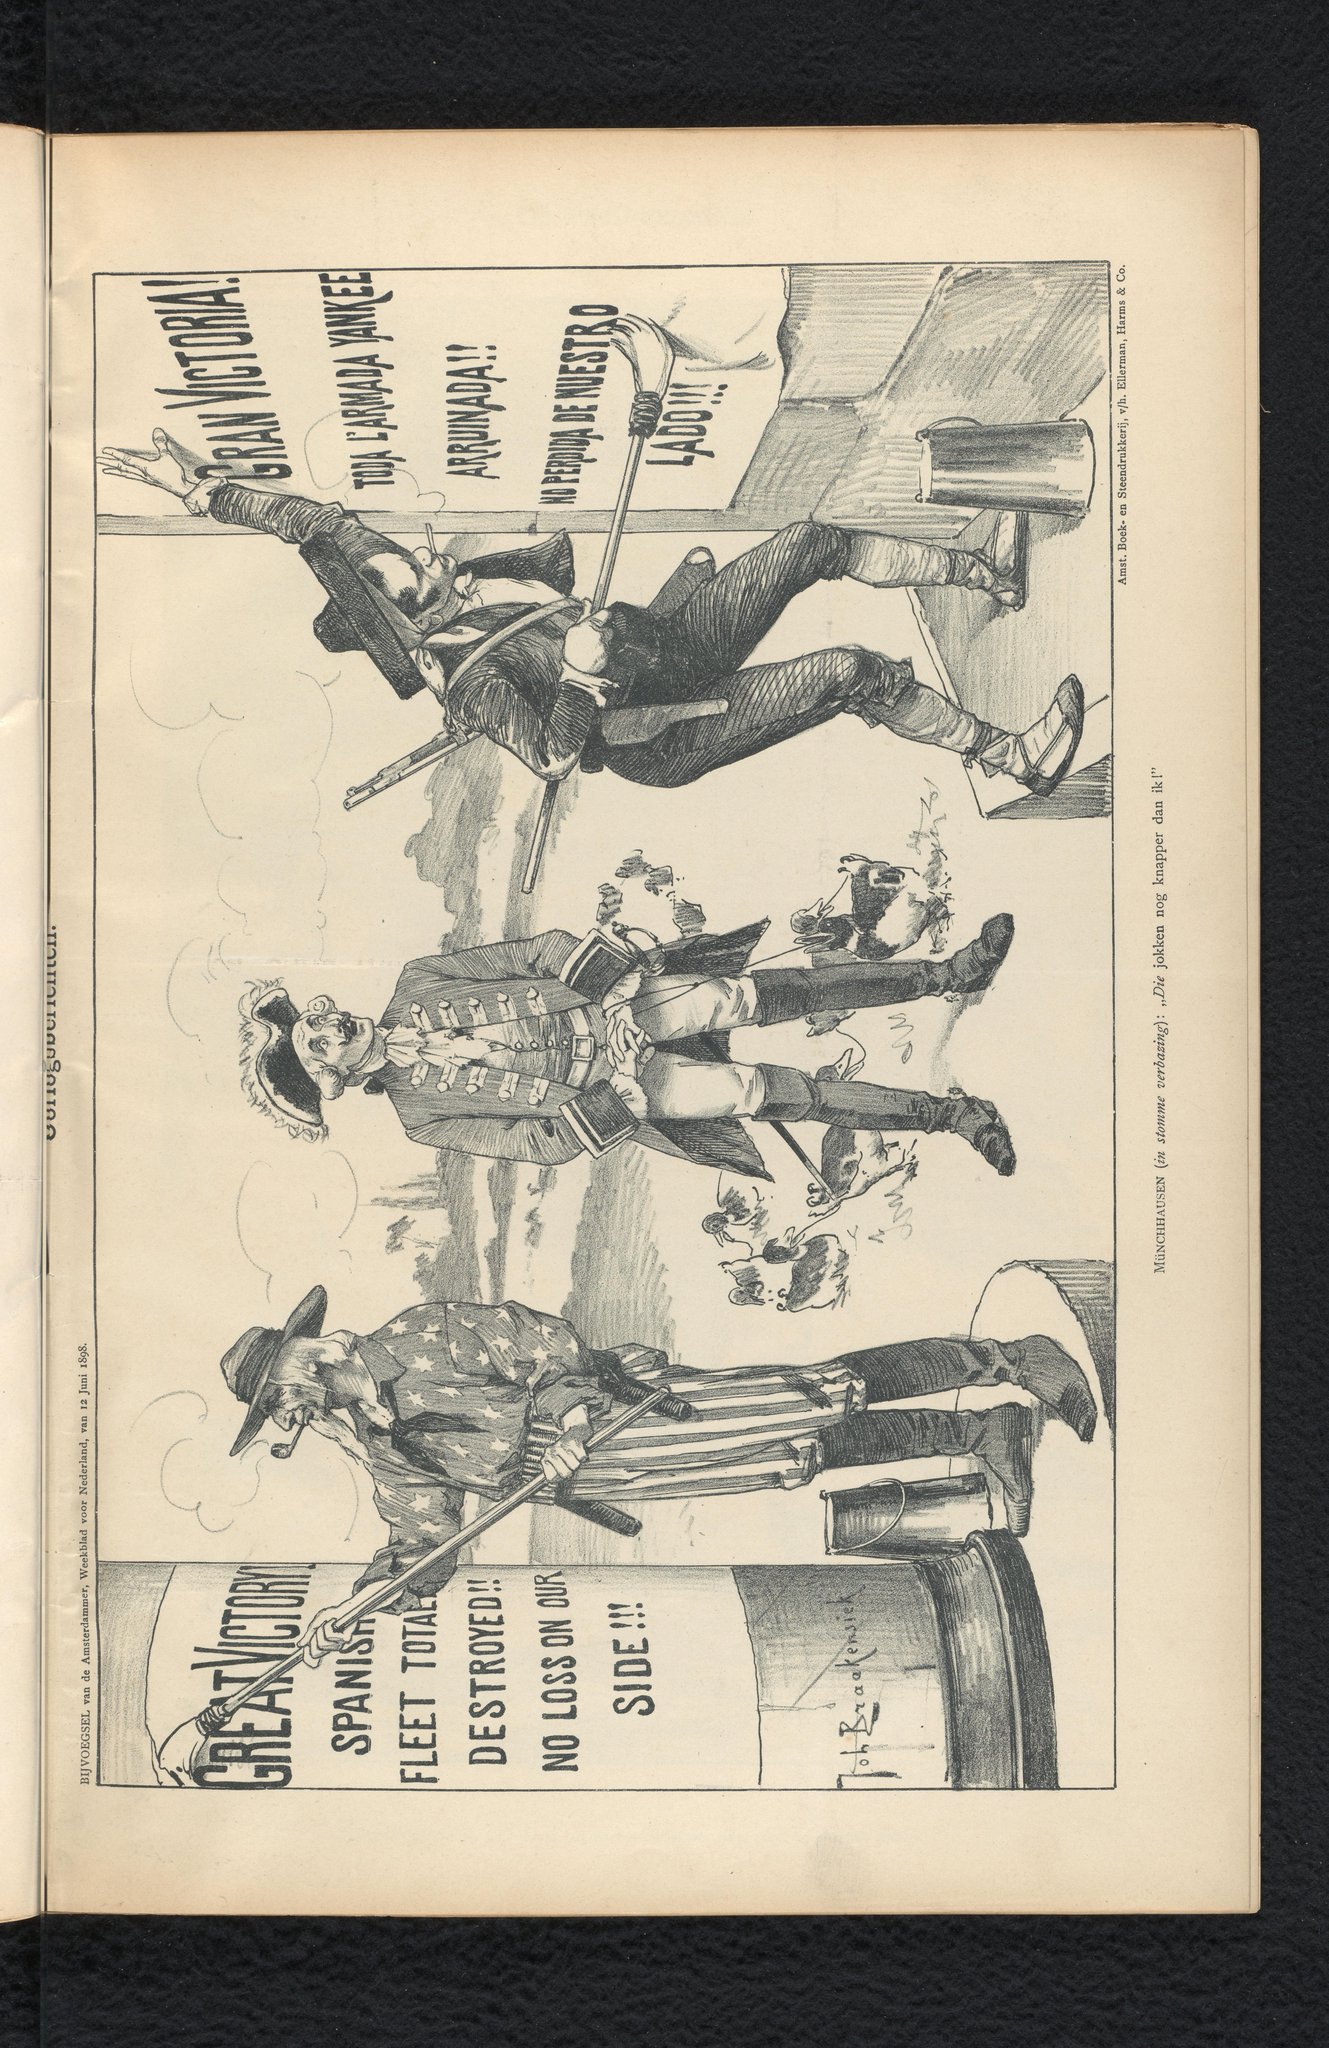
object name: cartoon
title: Oorlogsberichten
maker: johan braakensiek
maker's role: draughtsman, print maker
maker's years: 1858-1940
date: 1898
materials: paper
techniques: lithograph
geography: netherlands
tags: political propaganda, personifications of countries, nations, states, districts, etc., poster-pillar, baron münchausen, newspaper, news-sheet, political caricatures and satires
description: Baron von Münchhausen kijkt verbaasd toe hoe de Verenigde Staten (Uncle Sam) en Spanje allebei affiches plakken met propaganda over het verloop van de Spaans-Amerikaanse oorlog.